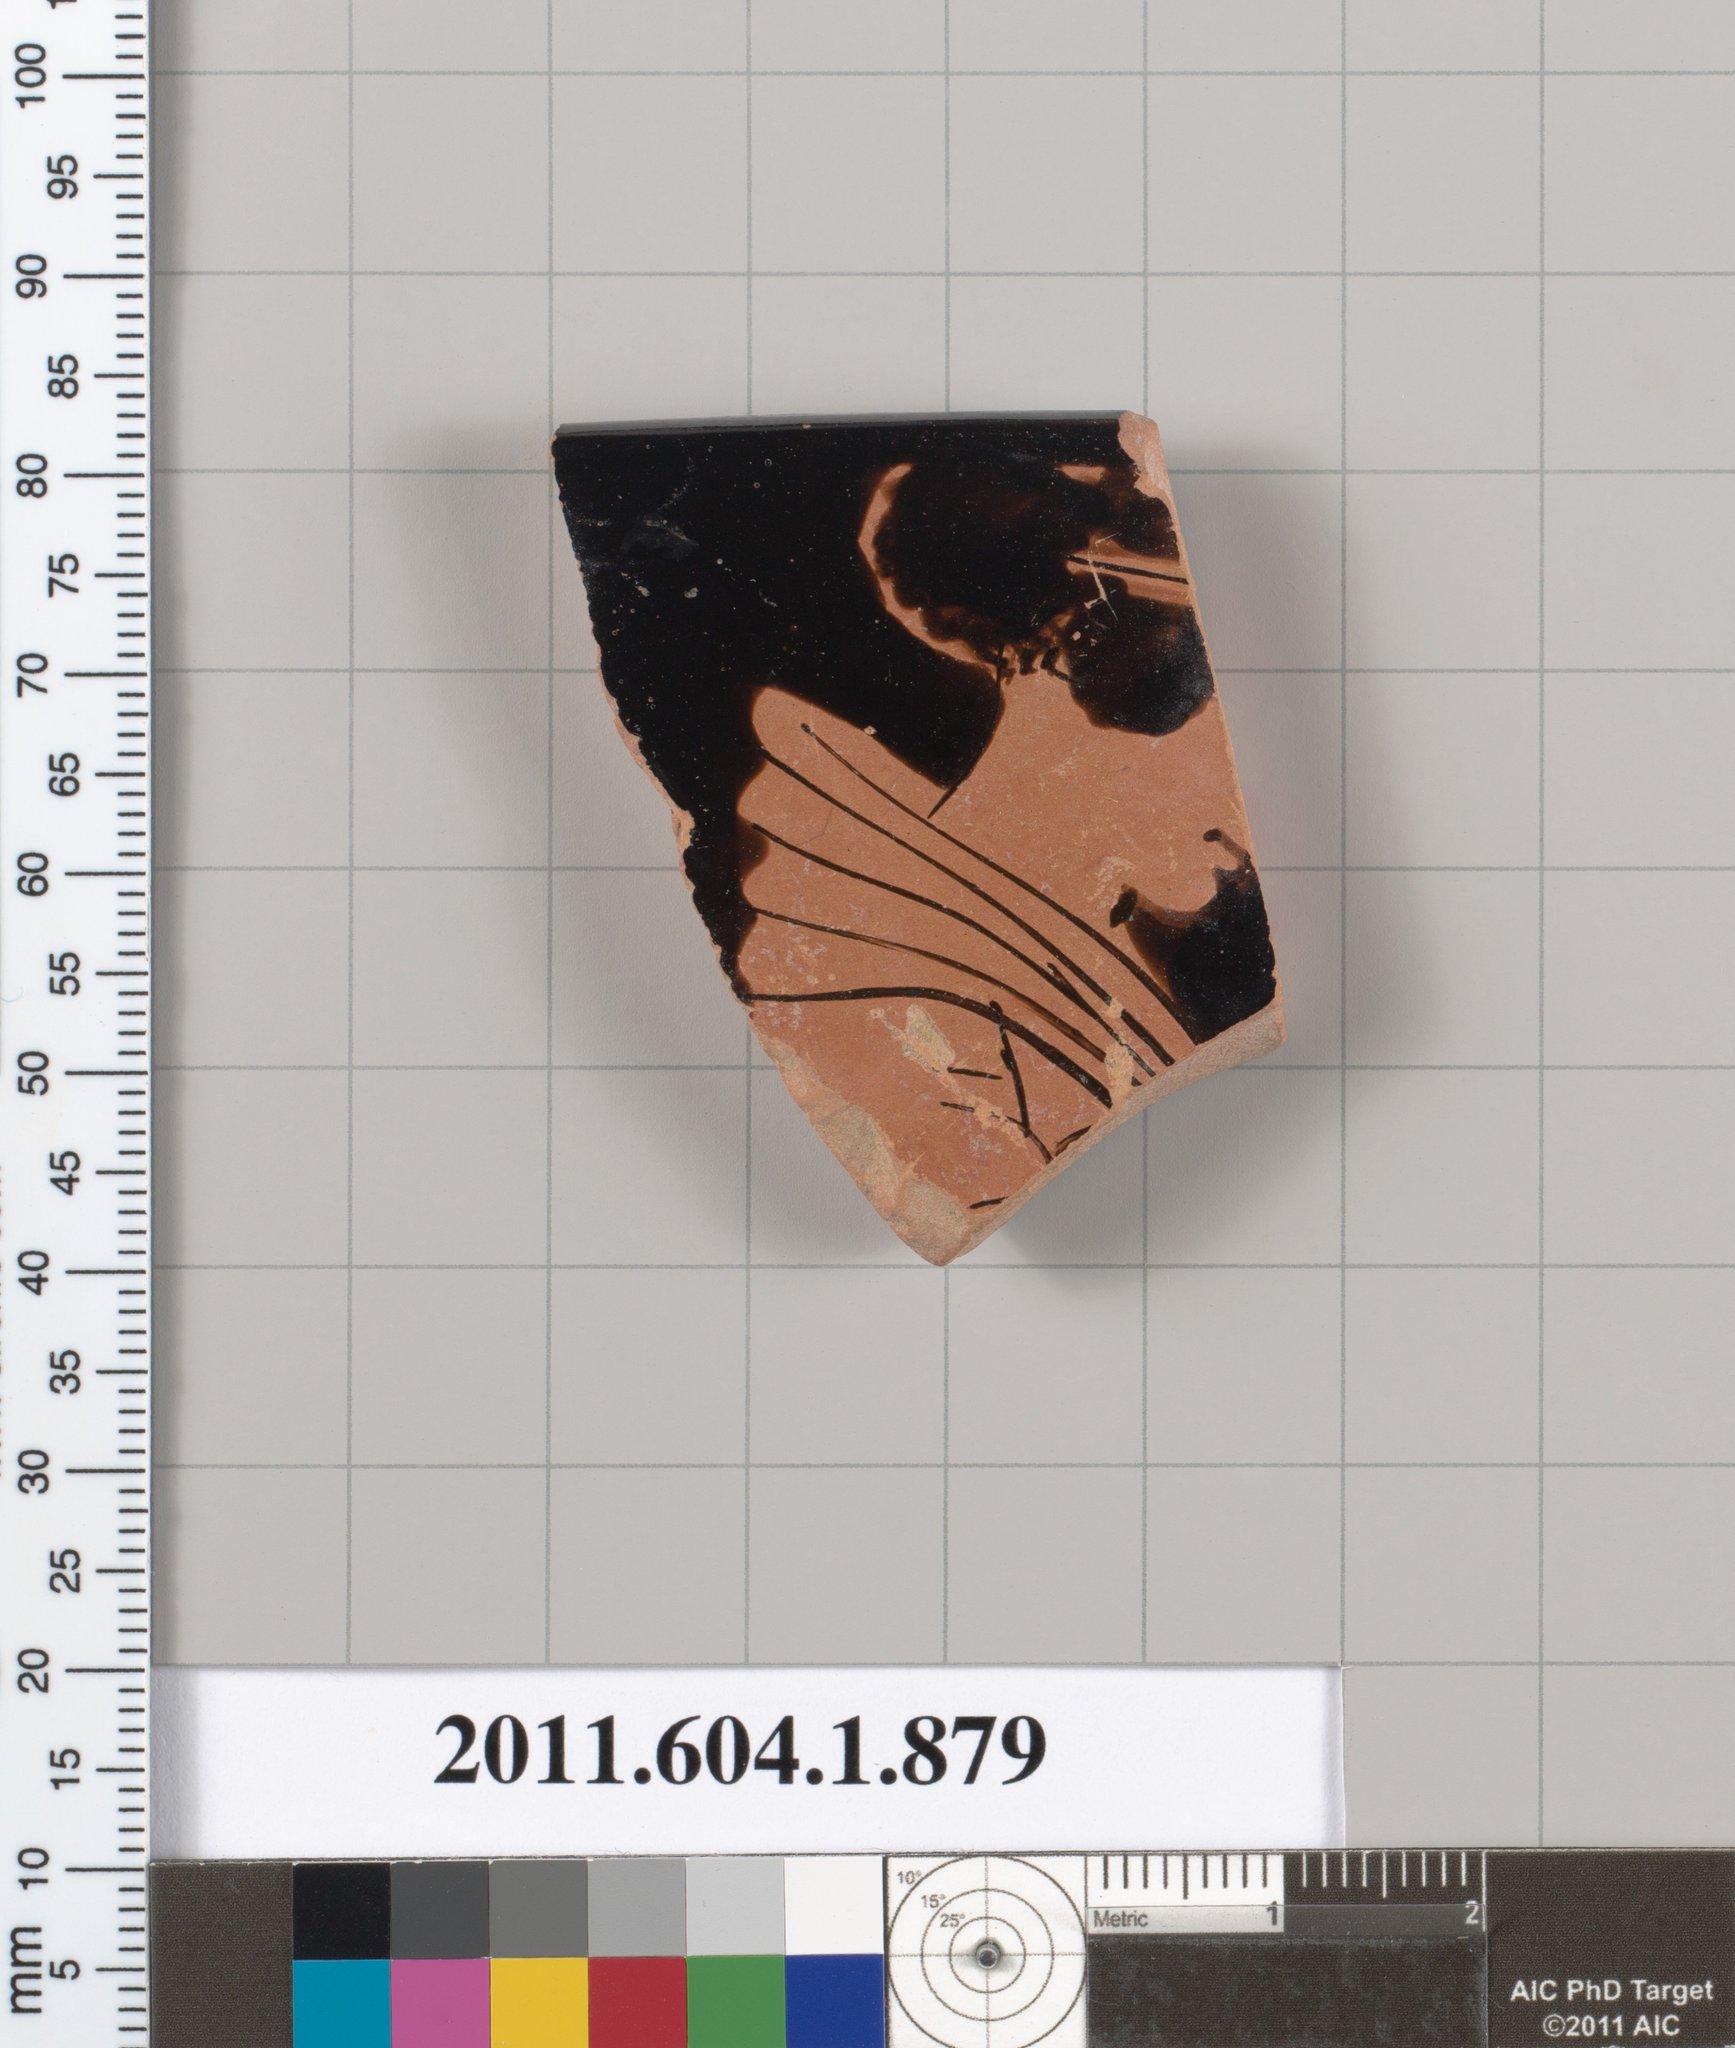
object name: kylix fragment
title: Terracotta rim fragment of a kylix or skyphos? (drinking cup)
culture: greek, attic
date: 475-451 BCE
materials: terracotta